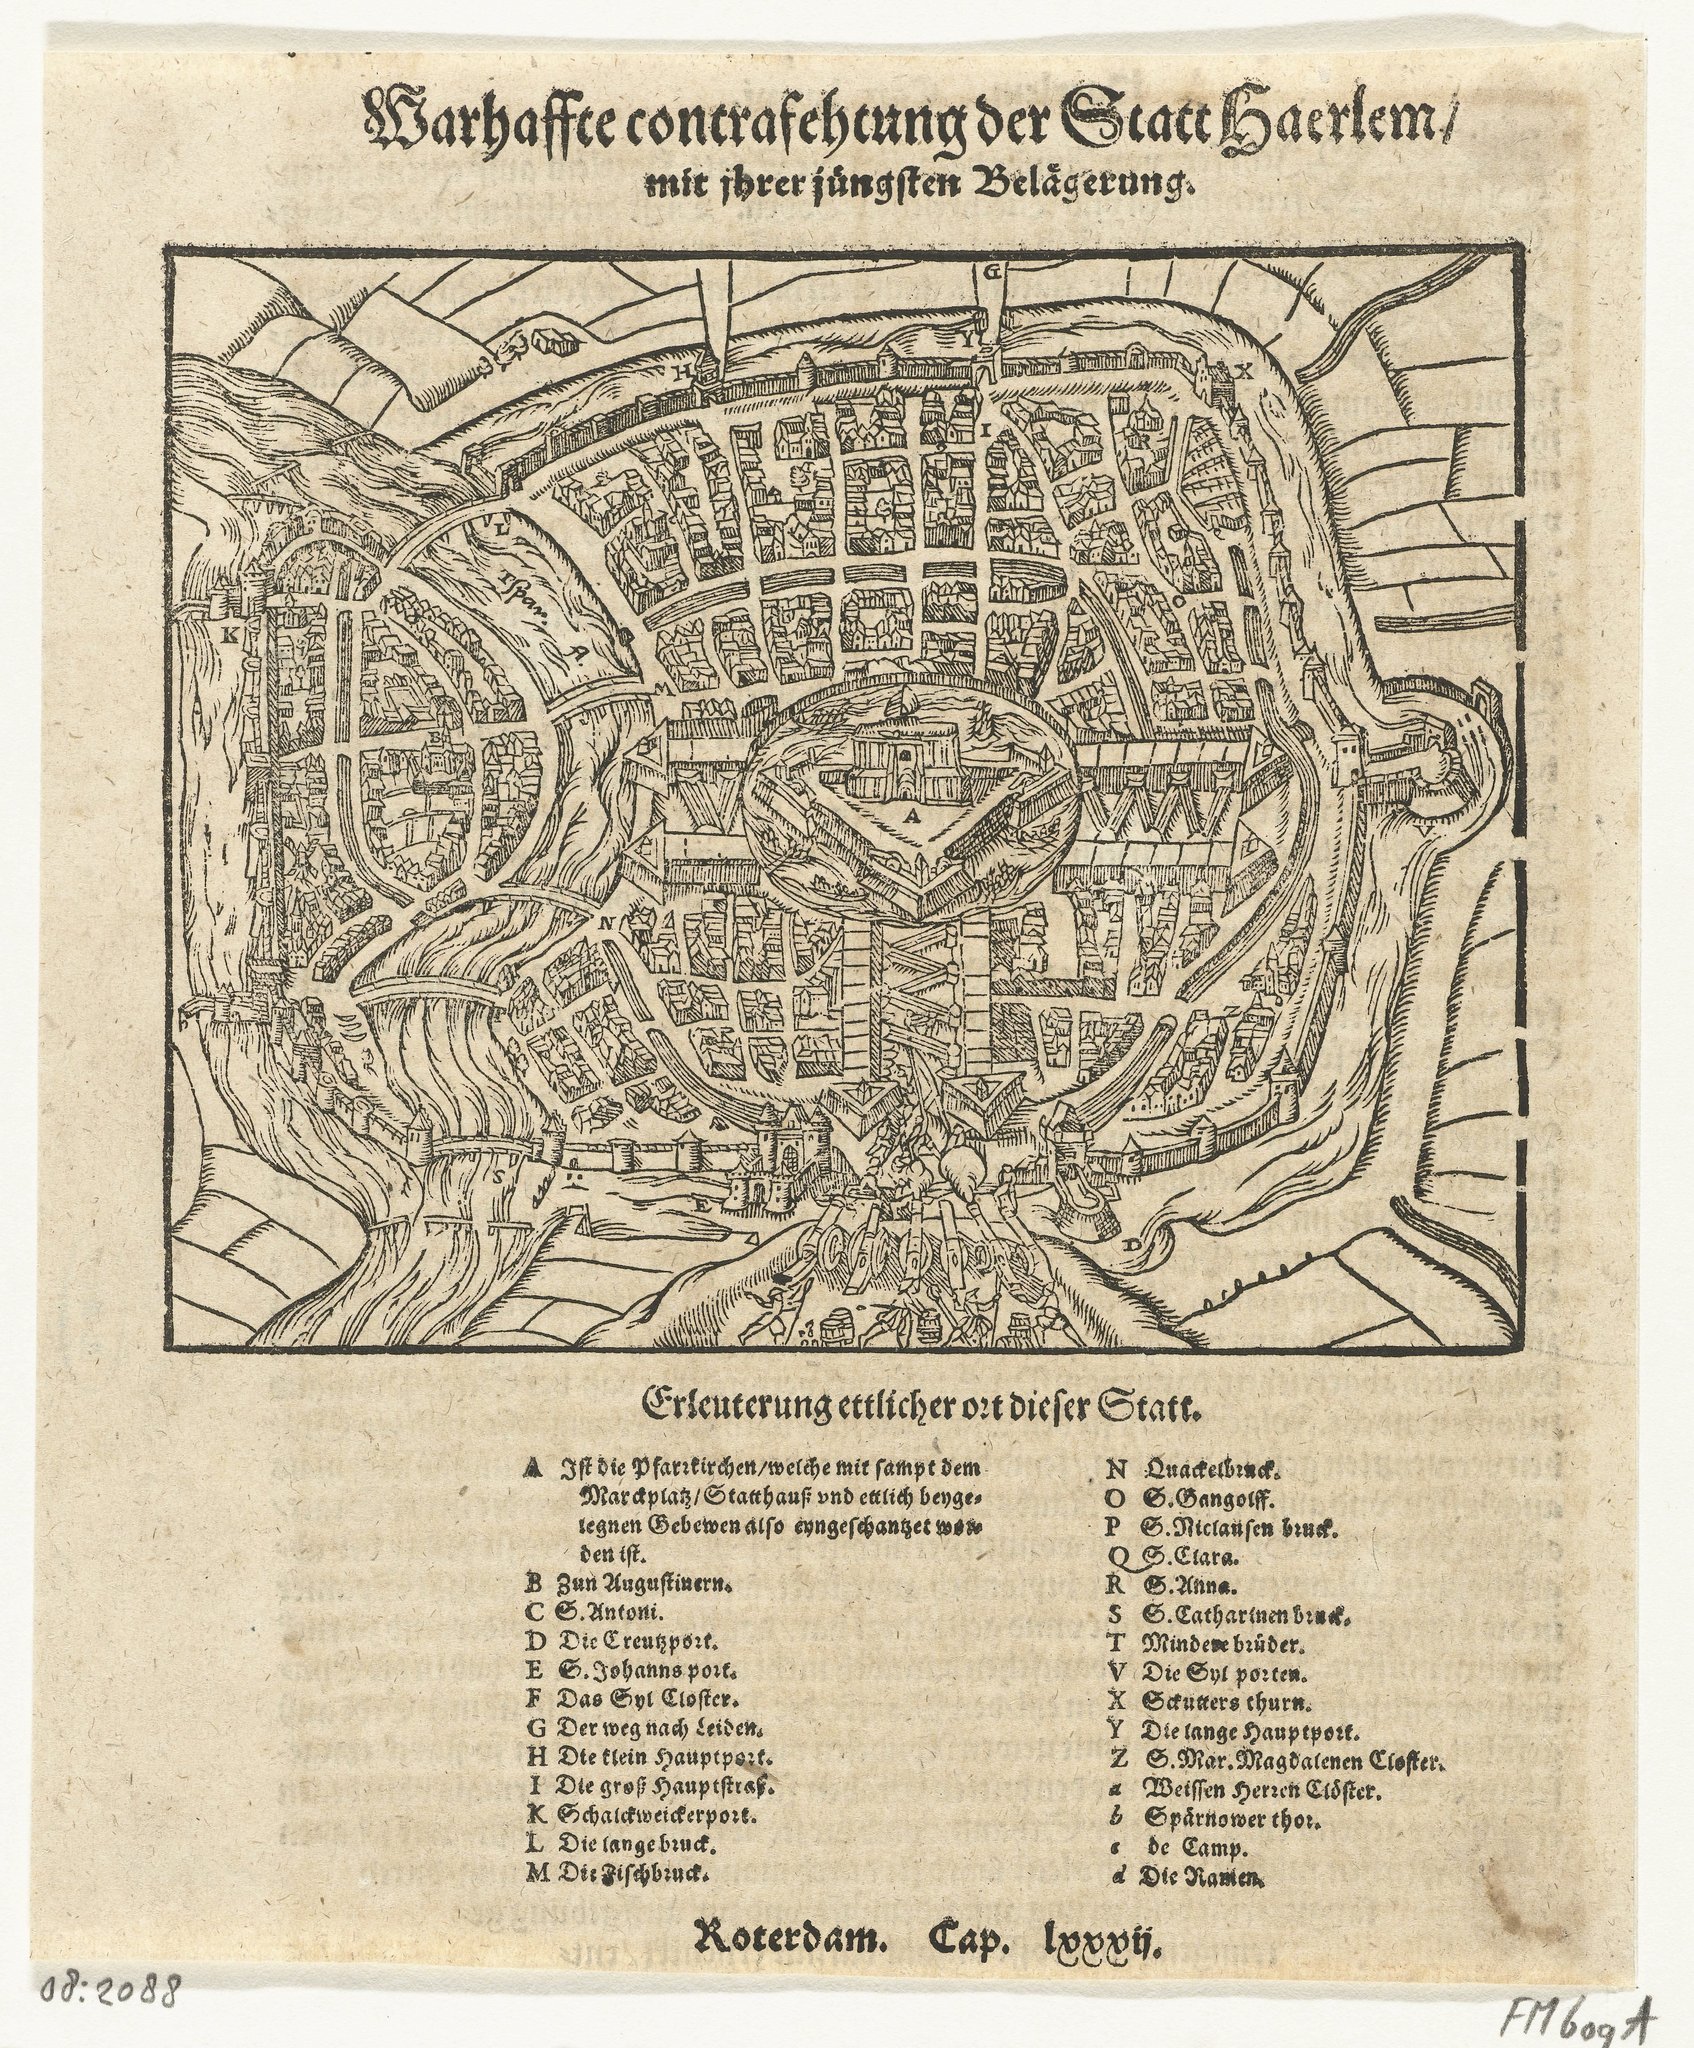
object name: print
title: Plattegrond met het beleg van Haarlem, 1572-1573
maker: Anonymous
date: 1572-1573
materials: paper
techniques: woodcut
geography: germany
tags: siege, position war, maps of cities, haarlem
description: Plattegrond met het beleg van Haarlem, 1572-1573. Onder de voorstelling de legenda A-Z en a-d in het Duits. Bedrukt op de achterzijde met tekst in het Duits.